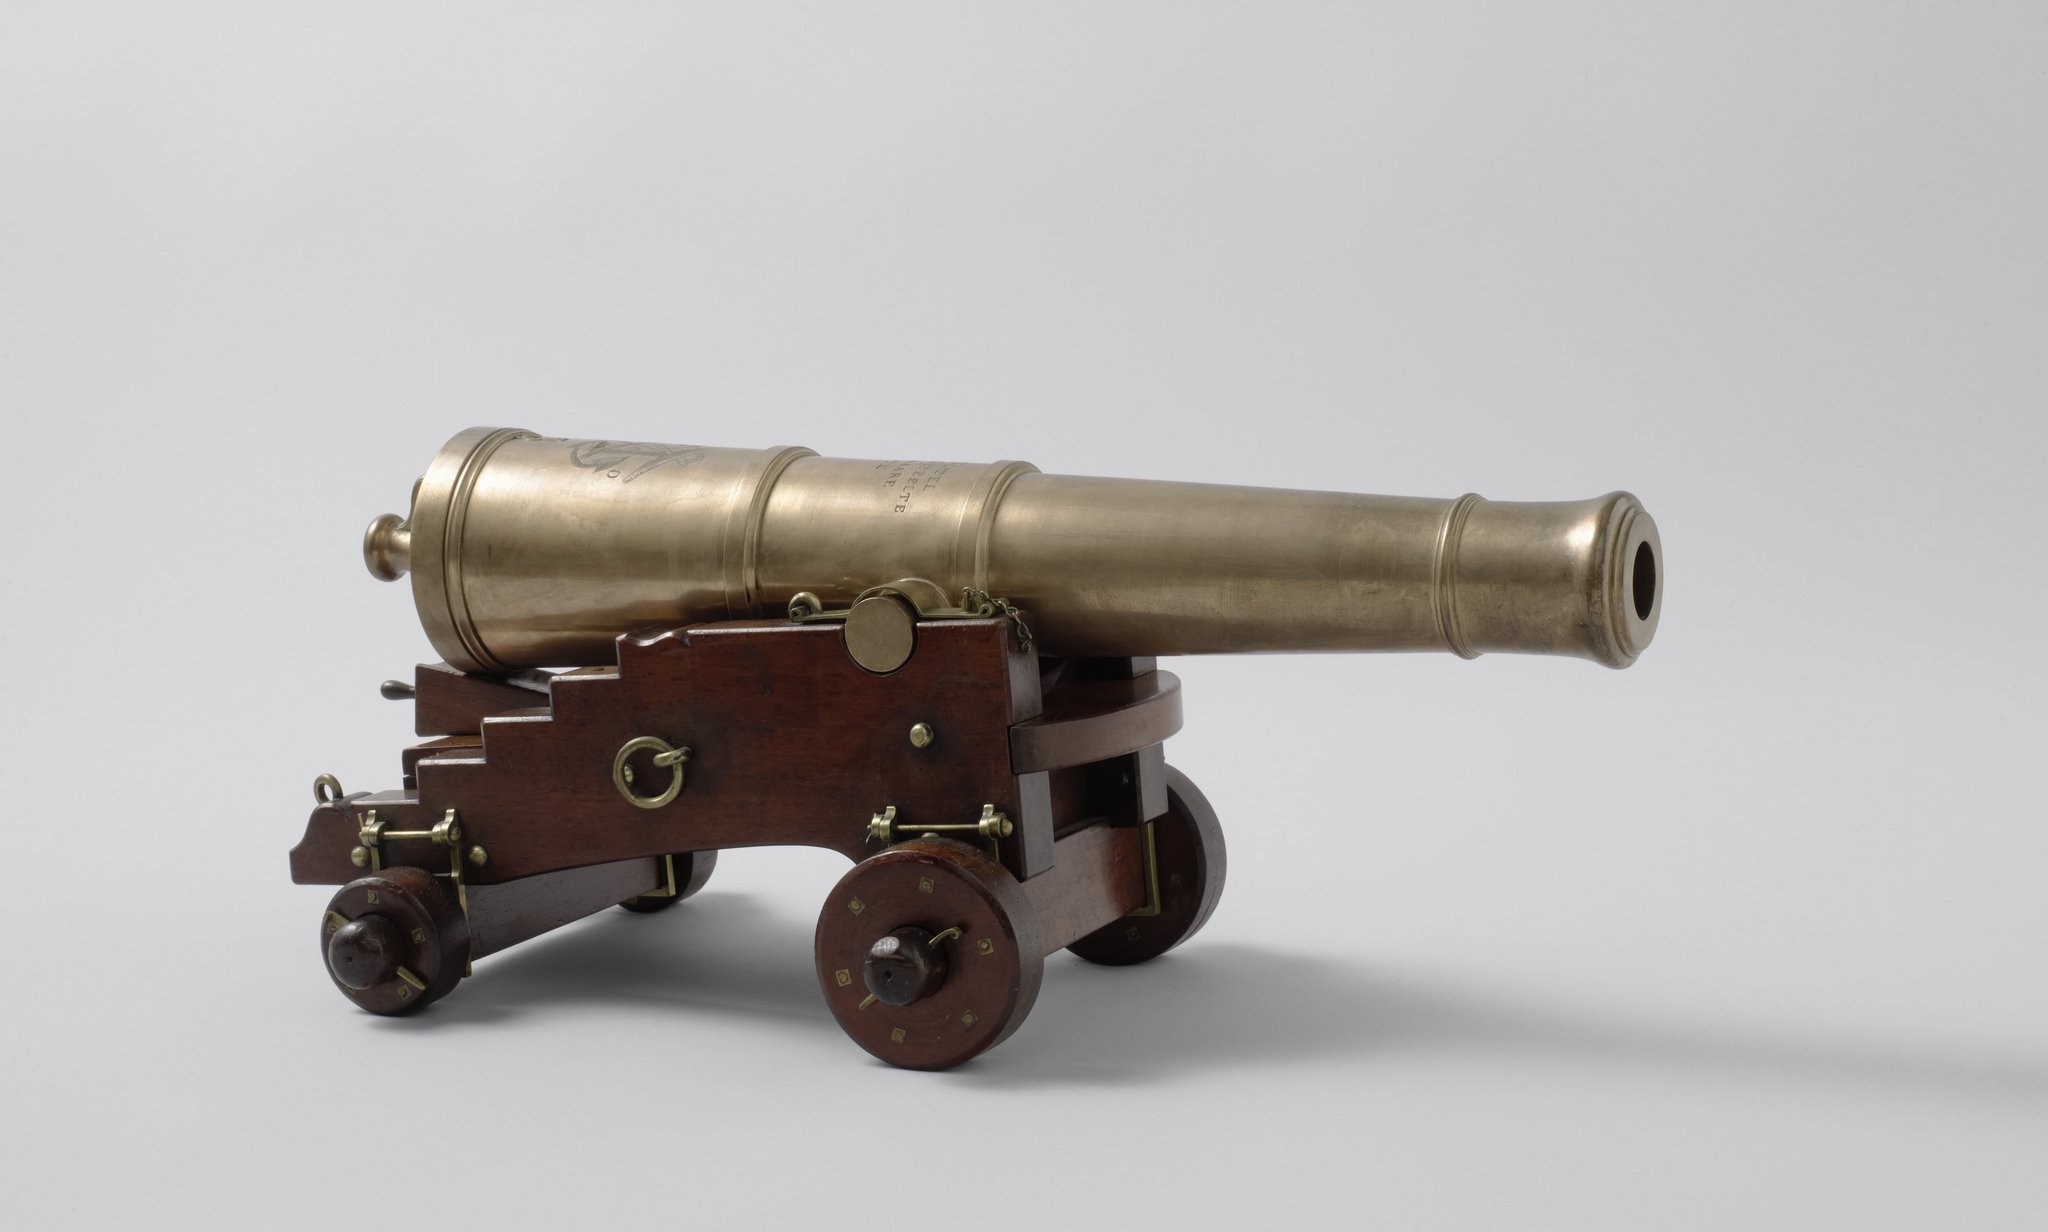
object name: demonstration model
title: Model of a 30-pounder cannon on a gun carriage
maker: Anonymous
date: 1800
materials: brass, bronze, wood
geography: rotterdam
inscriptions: inscription, on the barrel: ‘30 'TDR MODEL / EEN SESDE GEDEELTE / VAN DE WAARE GROOTE’, inscription, on the carriage: ‘M 30 P / 33.’, monogram, on the barrel: ‘Am 1800 M’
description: The heavy artillery on naval ships consisted of cannon mounted on gun carriages. The calibre – or fire power – of naval cannon was expressed in pounds, according to the weight of the projectiles. The set on this plank represents guns of decreasing calibre, ranging from 36 pounds (far left), 30, 24 and 18 pounds to 12 pounds.